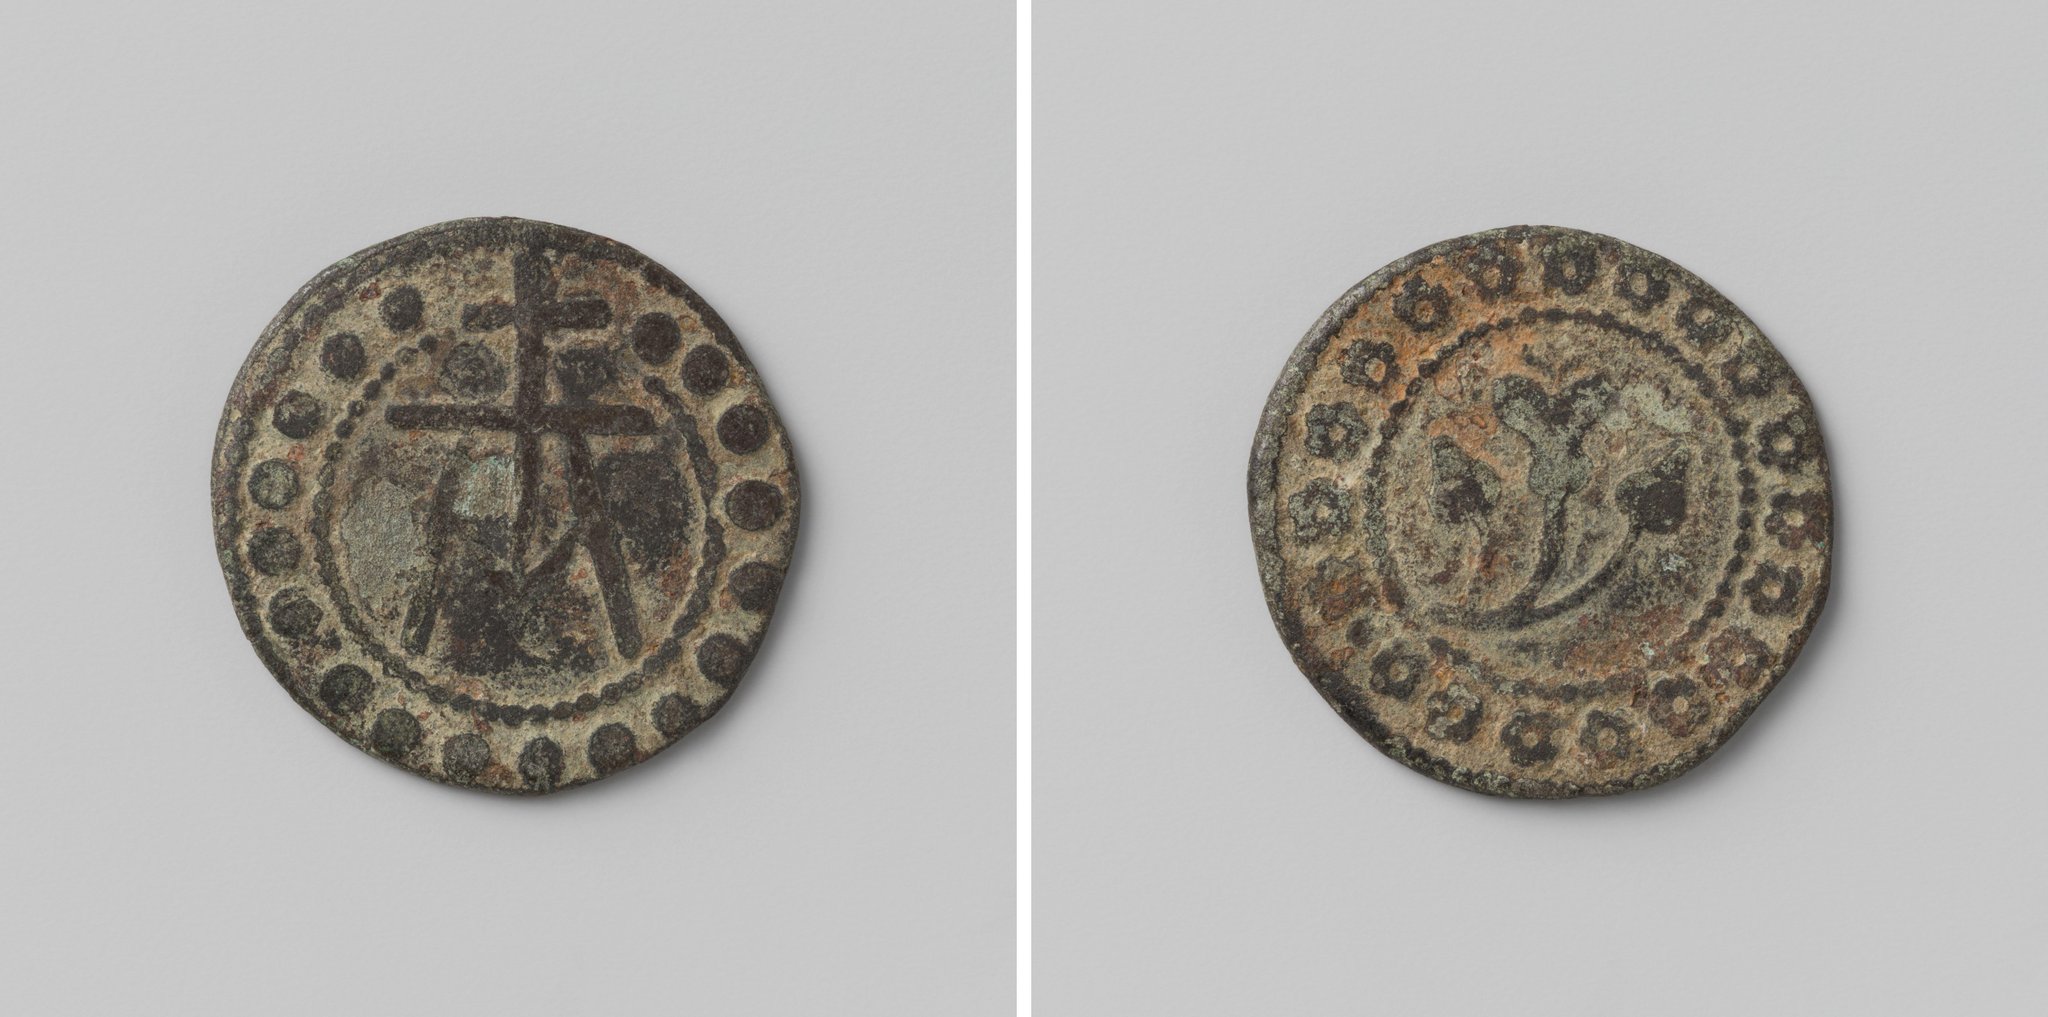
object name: devotional medal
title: Penning met monogram van letter A en kruisteken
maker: Anonymous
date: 1600-1750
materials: lead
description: Loden penning. Voorzijde: tot monogram verwerkte letter A en kruisteken binnen rand van stippen. Keerzijde: bloemblad binnen rand van stippen. Vermoedelijk een religieuze penning.